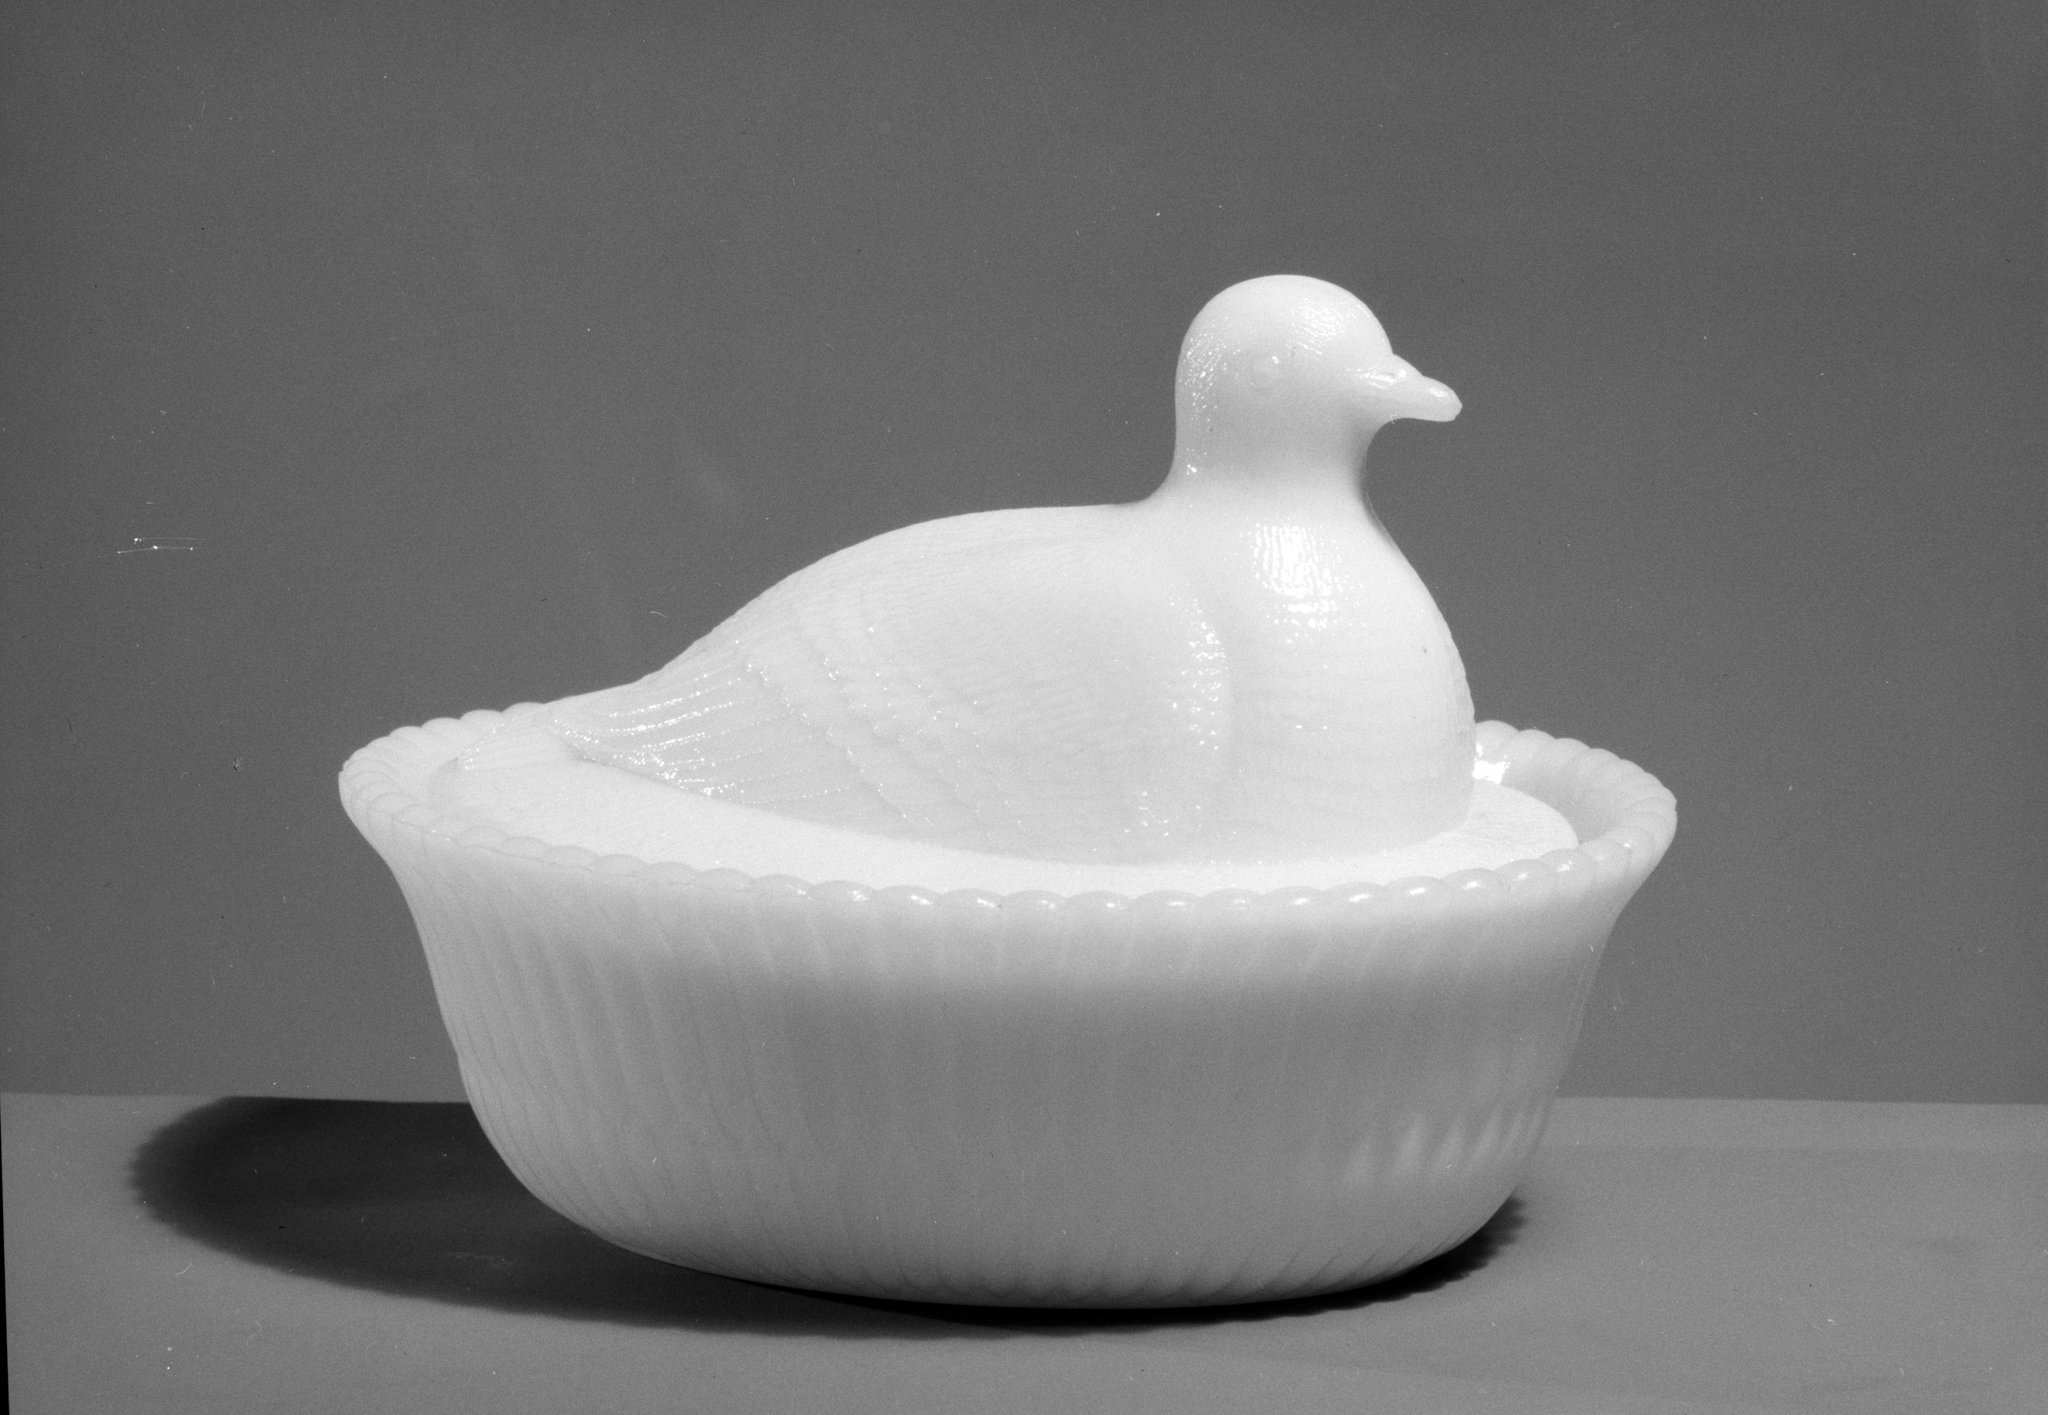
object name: dish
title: Figure Dish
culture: american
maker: mckee and brothers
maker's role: maker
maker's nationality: american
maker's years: 1856-1889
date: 1880-1890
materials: glass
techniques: pressed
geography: united states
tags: birds